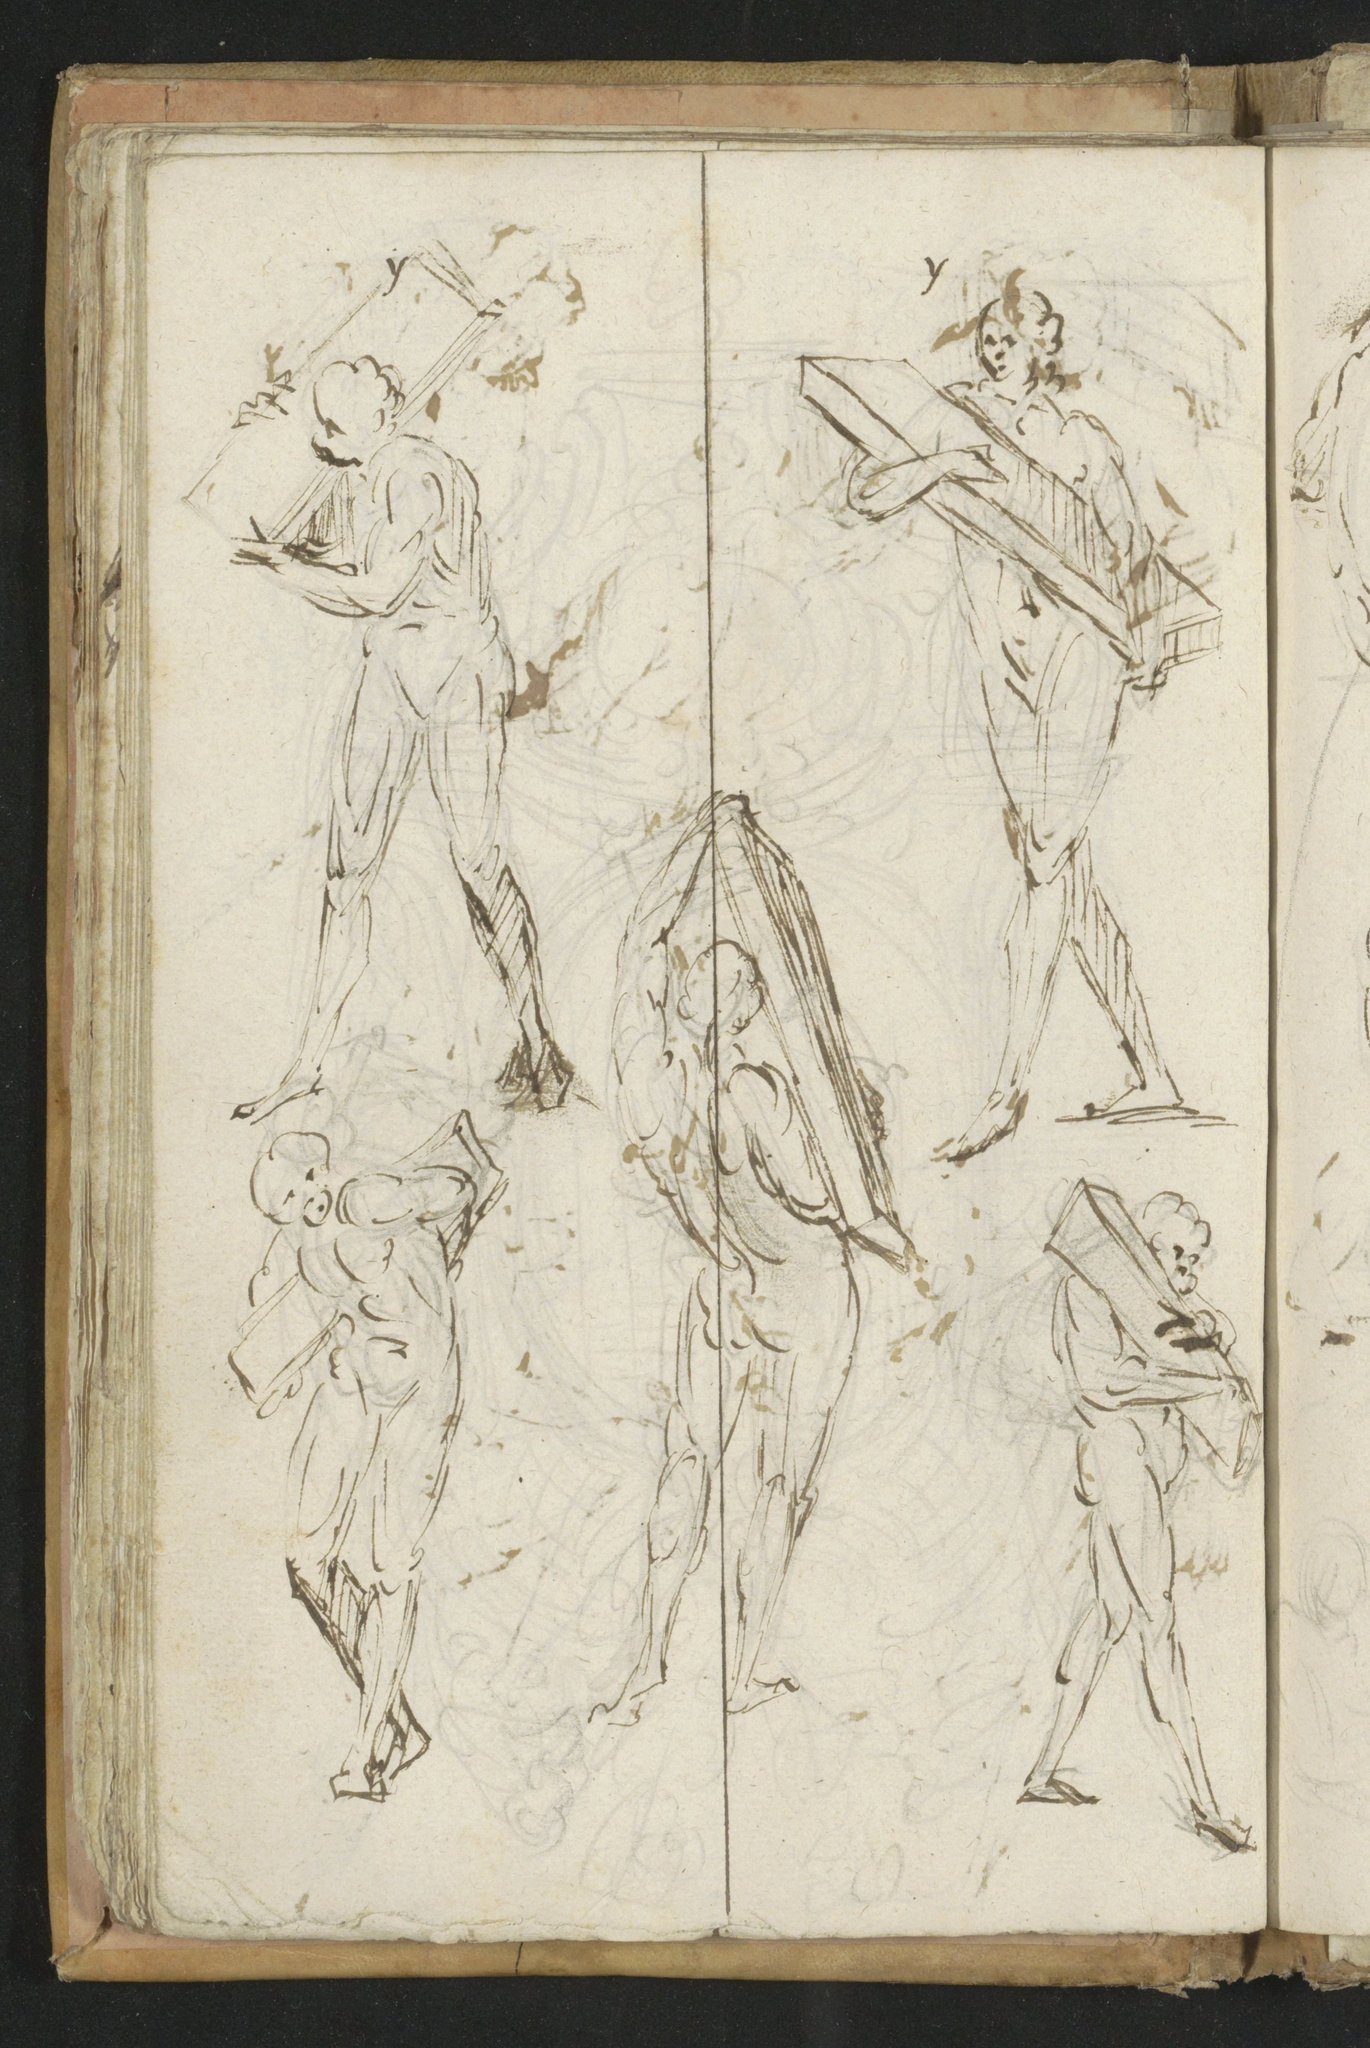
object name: sketchbook leaf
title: Vijf naakte mannen die balken of tabletten dragen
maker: Anonymous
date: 1658-1728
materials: ink, paper, pencil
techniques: pen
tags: carrying something, the (nude) human figure; 'corpo humano' (ripa)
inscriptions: annotation: ‘y y’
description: Blad 20 verso uit een schetsboek met 33 bladen.